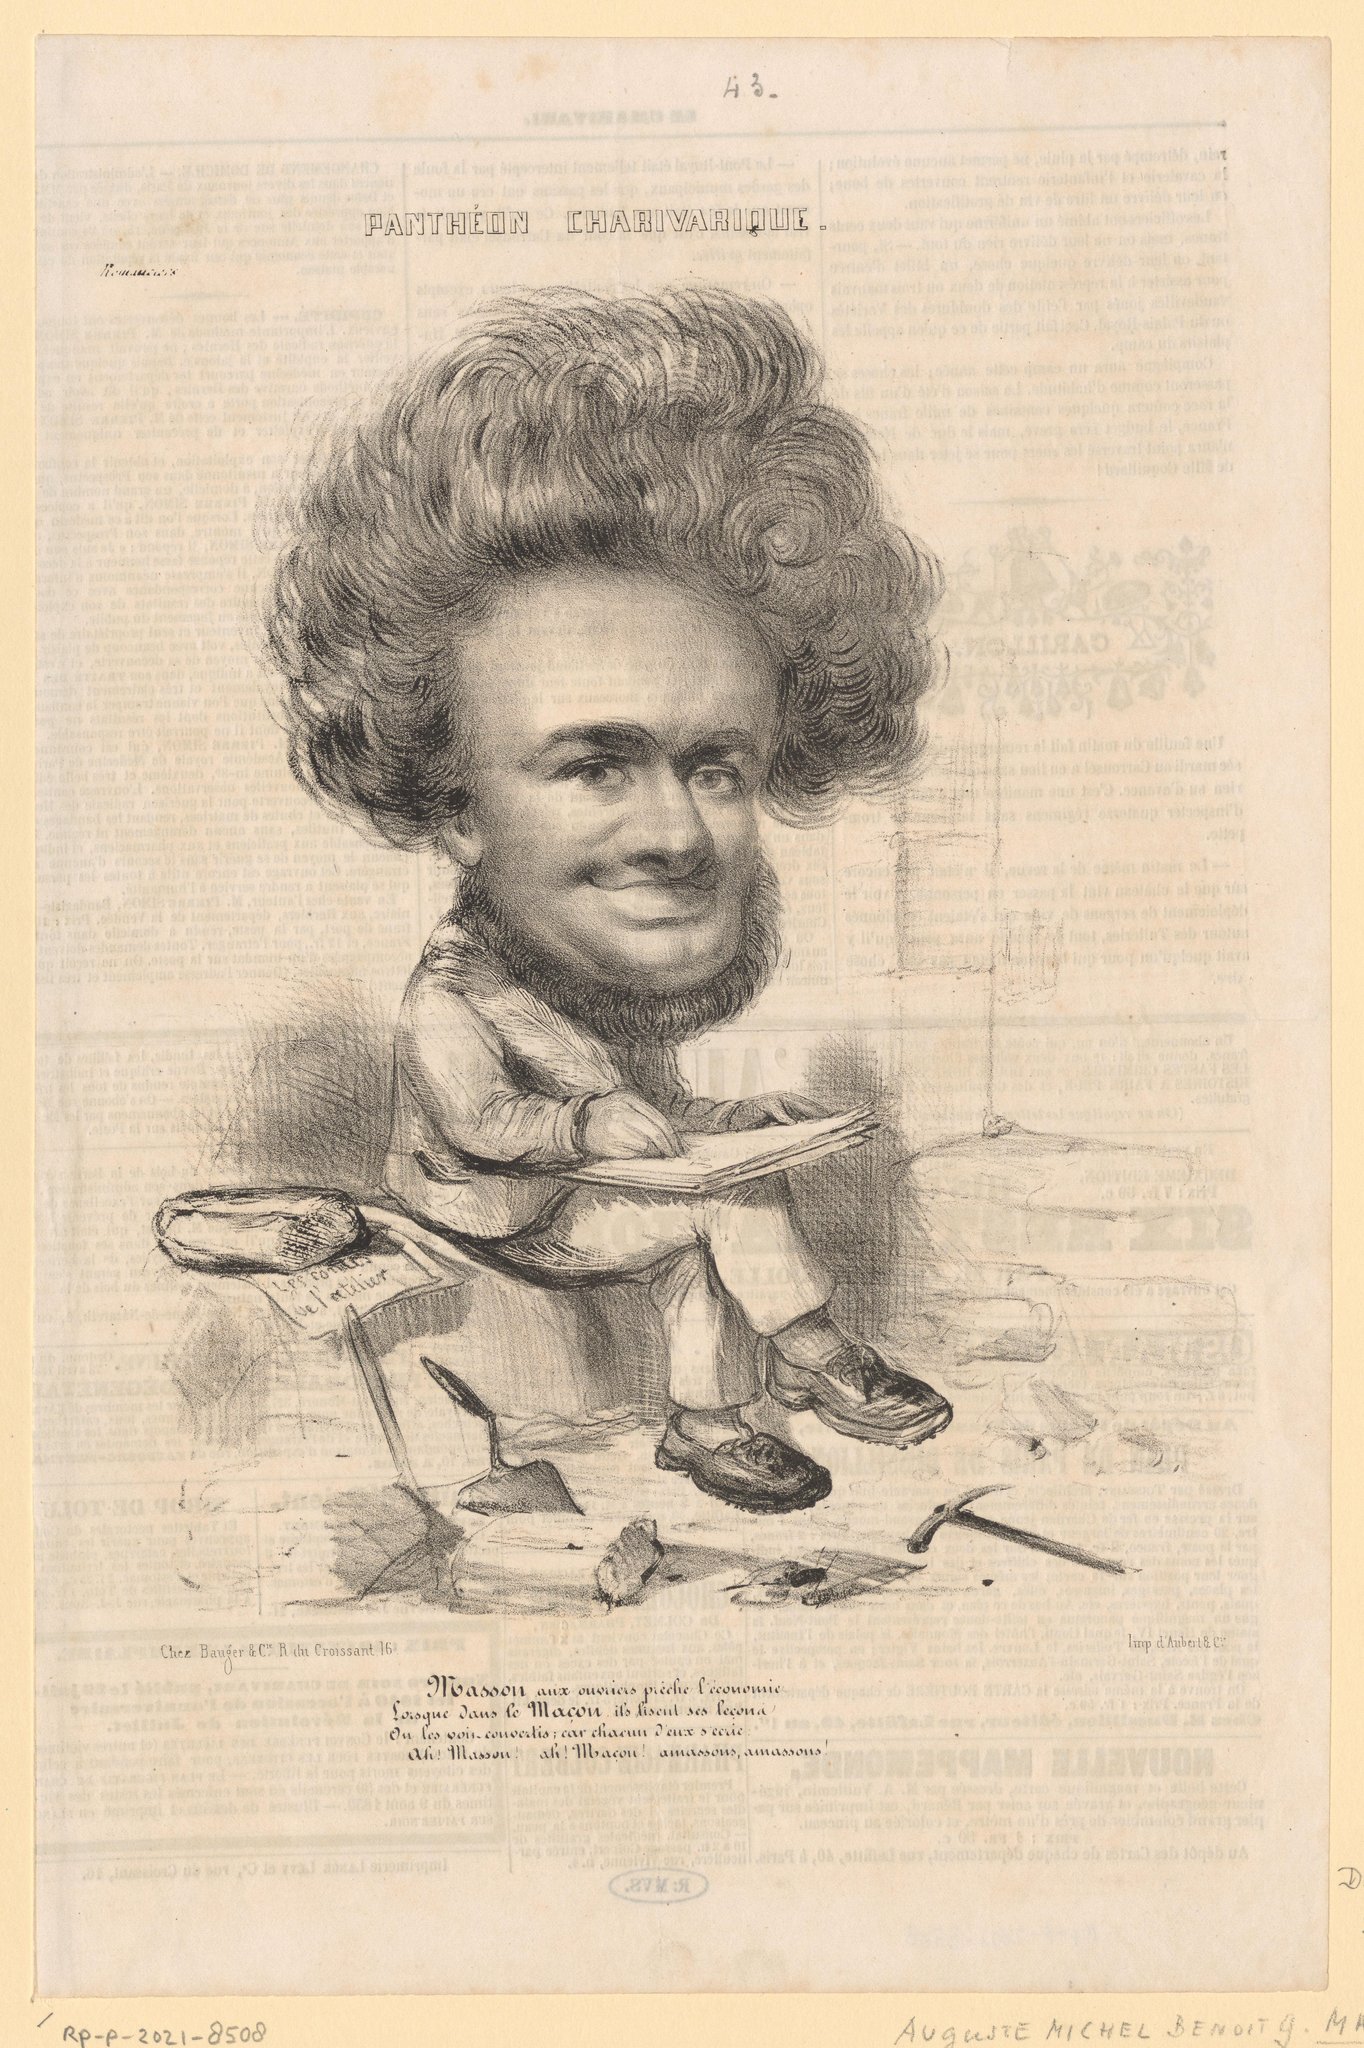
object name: cartoon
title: Panthéon Charivarique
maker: Anonymous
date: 1841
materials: paper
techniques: letterpress printing, lithograph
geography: paris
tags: caricatures (human types), historical persons, portrait of a writer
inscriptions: collector's mark: Lugt 2228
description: Uit de serie: Panthéon charivarique, bestaande uit 100 portretten van tekenaars, schrijvers, schilders, beeldhouwers, musici en acteurs. Prent uit: Le Charivari, 1841.